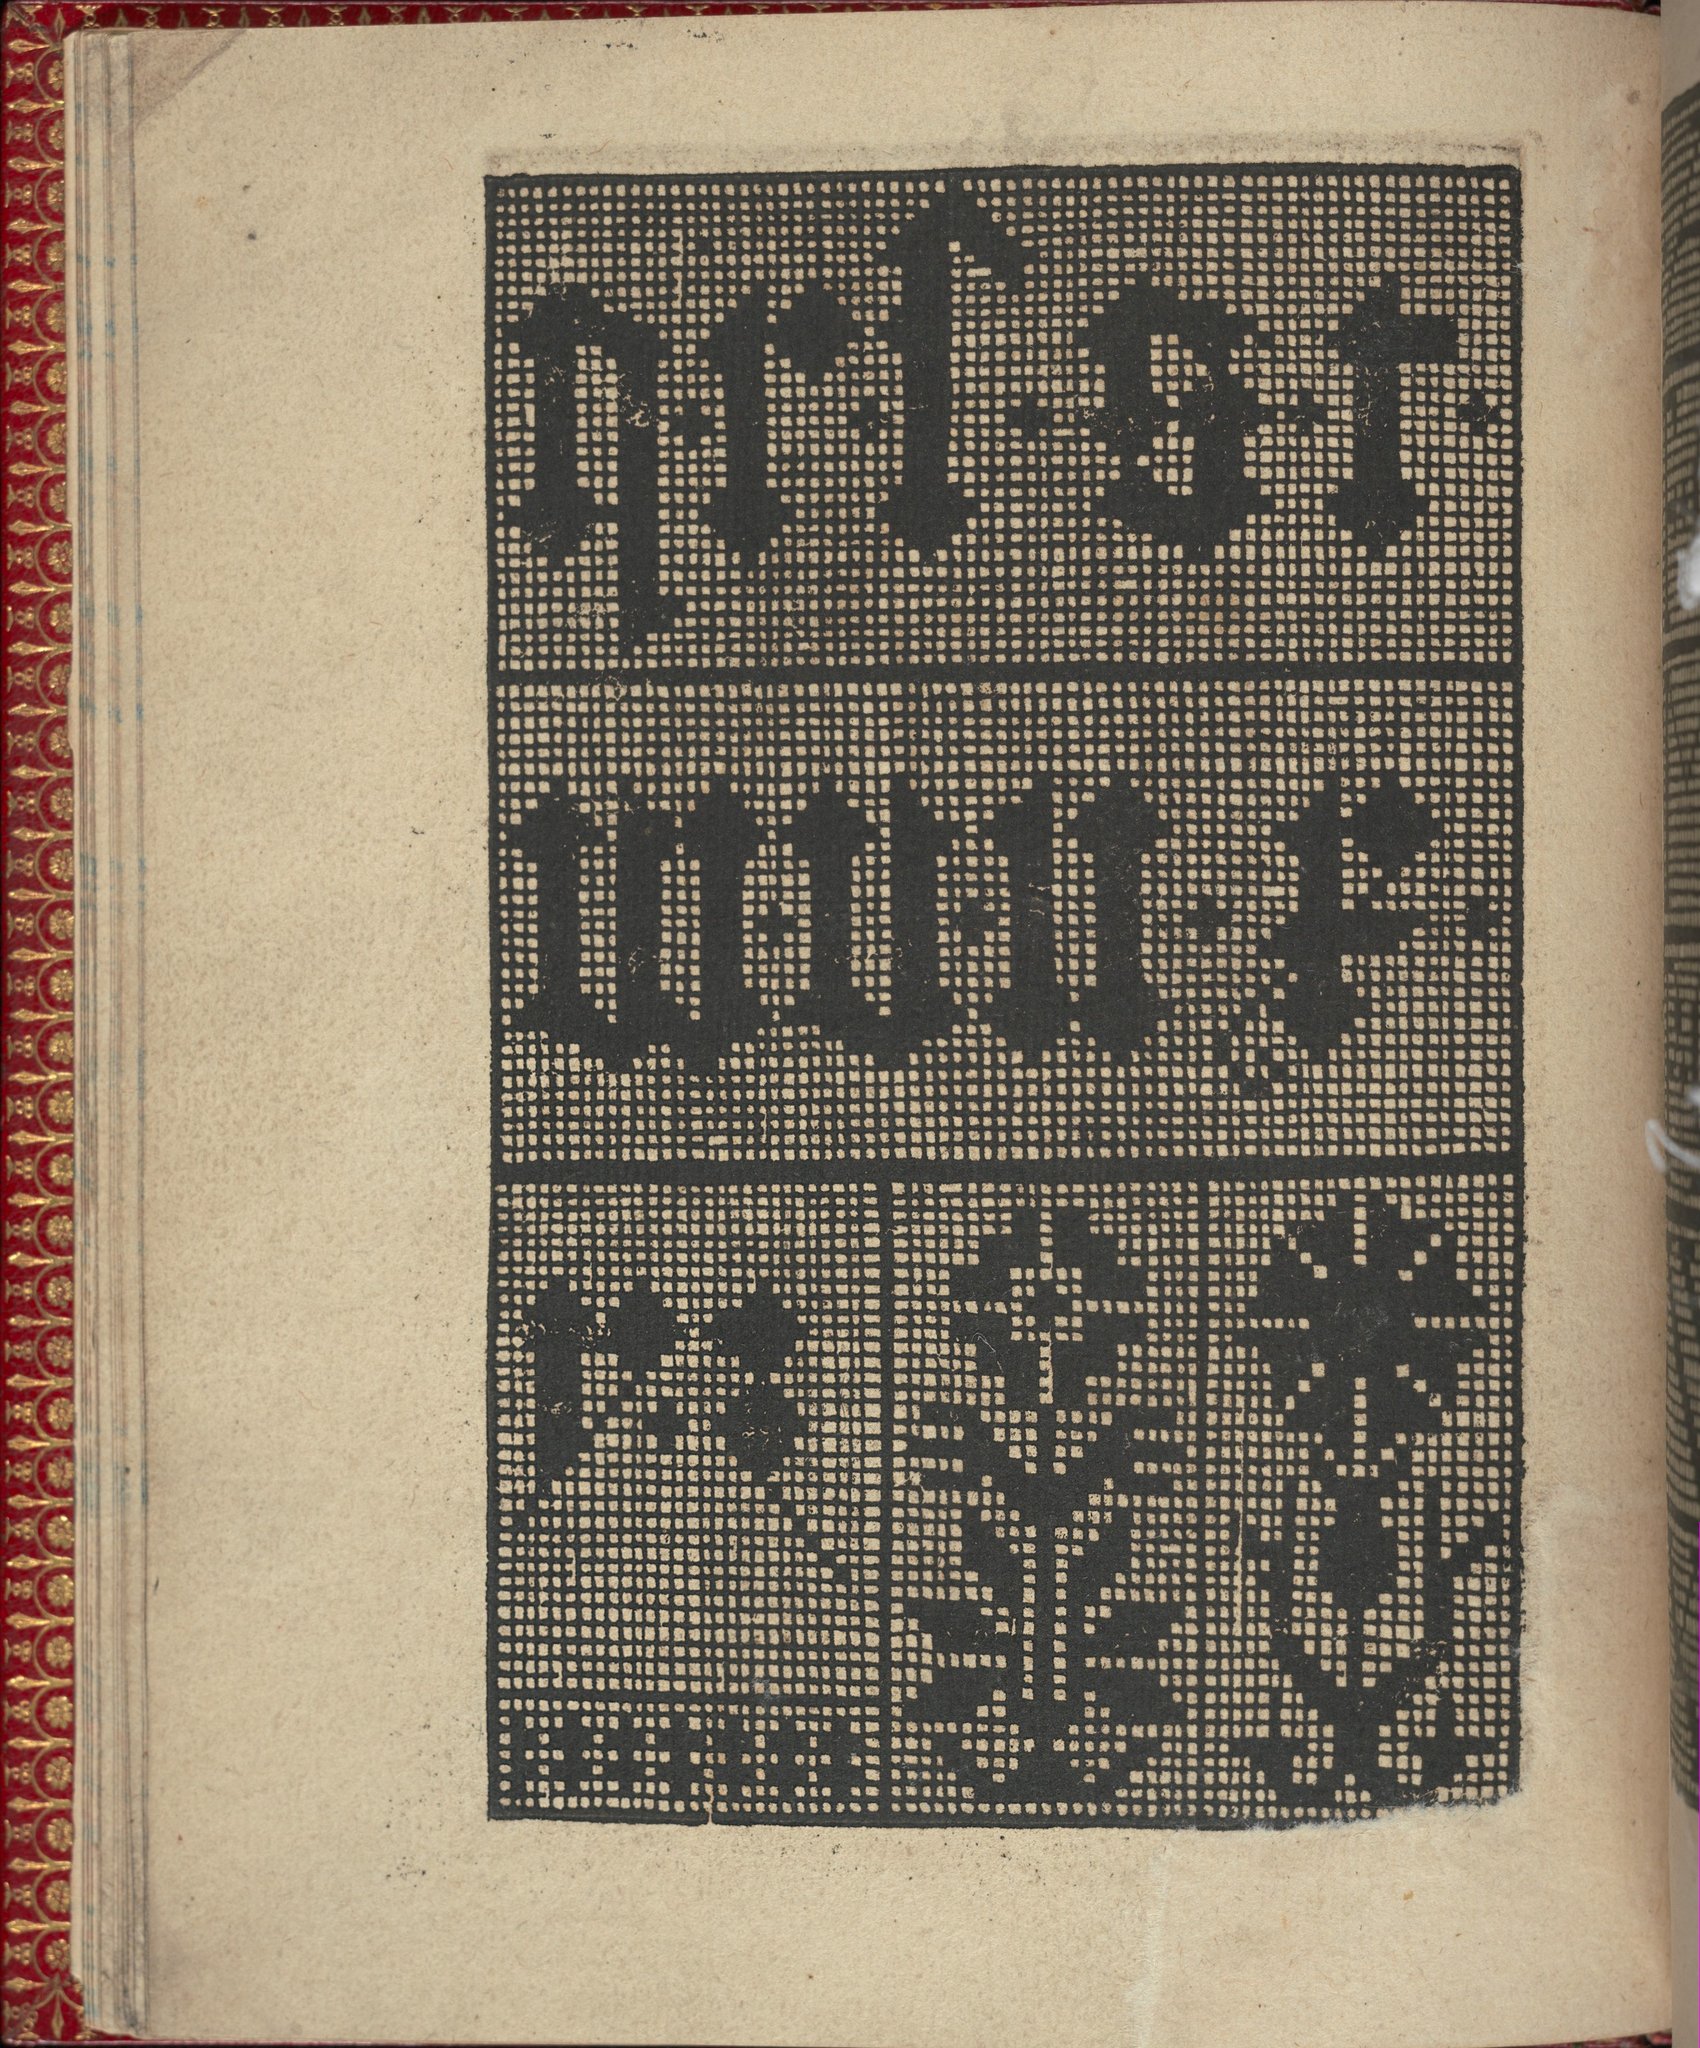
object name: book print ornament architecture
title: Ce est ung tractat de la noble art de leguille ascavoir ouvraiges de spaigne... page 7 (verso)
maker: willem vosterman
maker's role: printer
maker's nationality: netherlandish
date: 1527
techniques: woodcut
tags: ornament